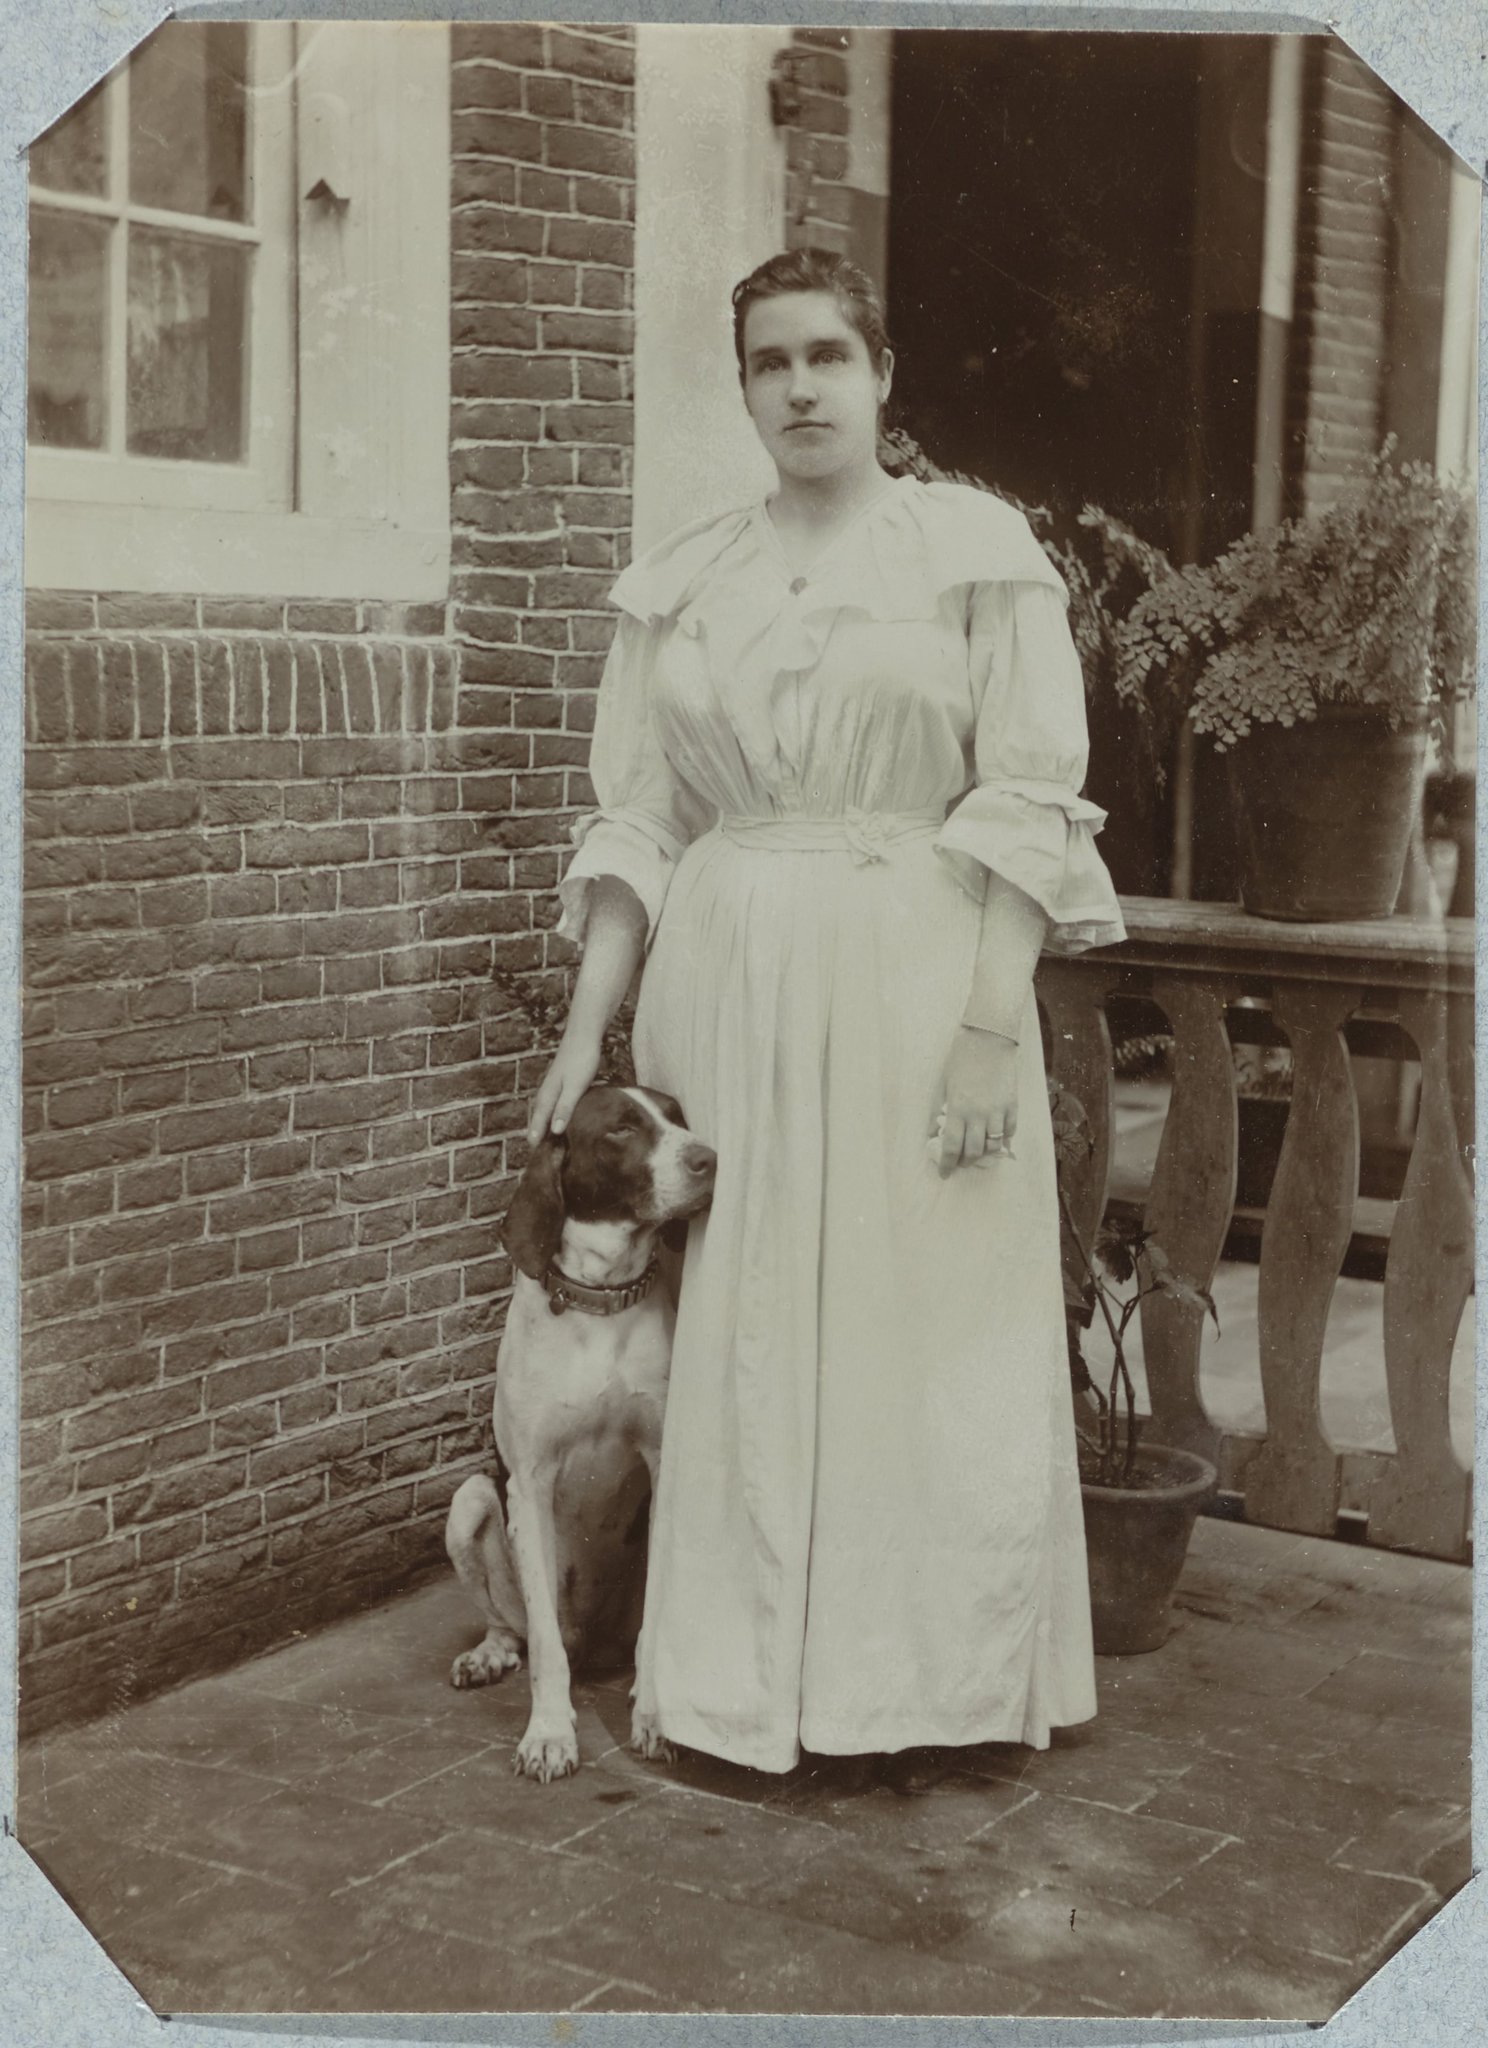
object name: photograph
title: Dolly en onze trouwe Hector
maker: théodore van lelyveld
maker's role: painter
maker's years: 1867-1954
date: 1895-1896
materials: photographic support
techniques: collodion silver print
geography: suriname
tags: nijmegen, historical persons - bb - woman, dog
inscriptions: inscription: ‘Dolly en onze trouwe Hector’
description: Portret van Dolly, de vrouw van de fotograaf, staande achter het huis aan de Gravenstraat te Paramaribo, met de hond Hector. Fotoafdruk in een fotoalbum van Théodore van Lelyveld over Suriname uit 1895-1898.